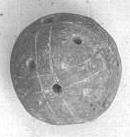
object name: pottery rattle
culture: aztec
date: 1200-1521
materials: clay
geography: mexico